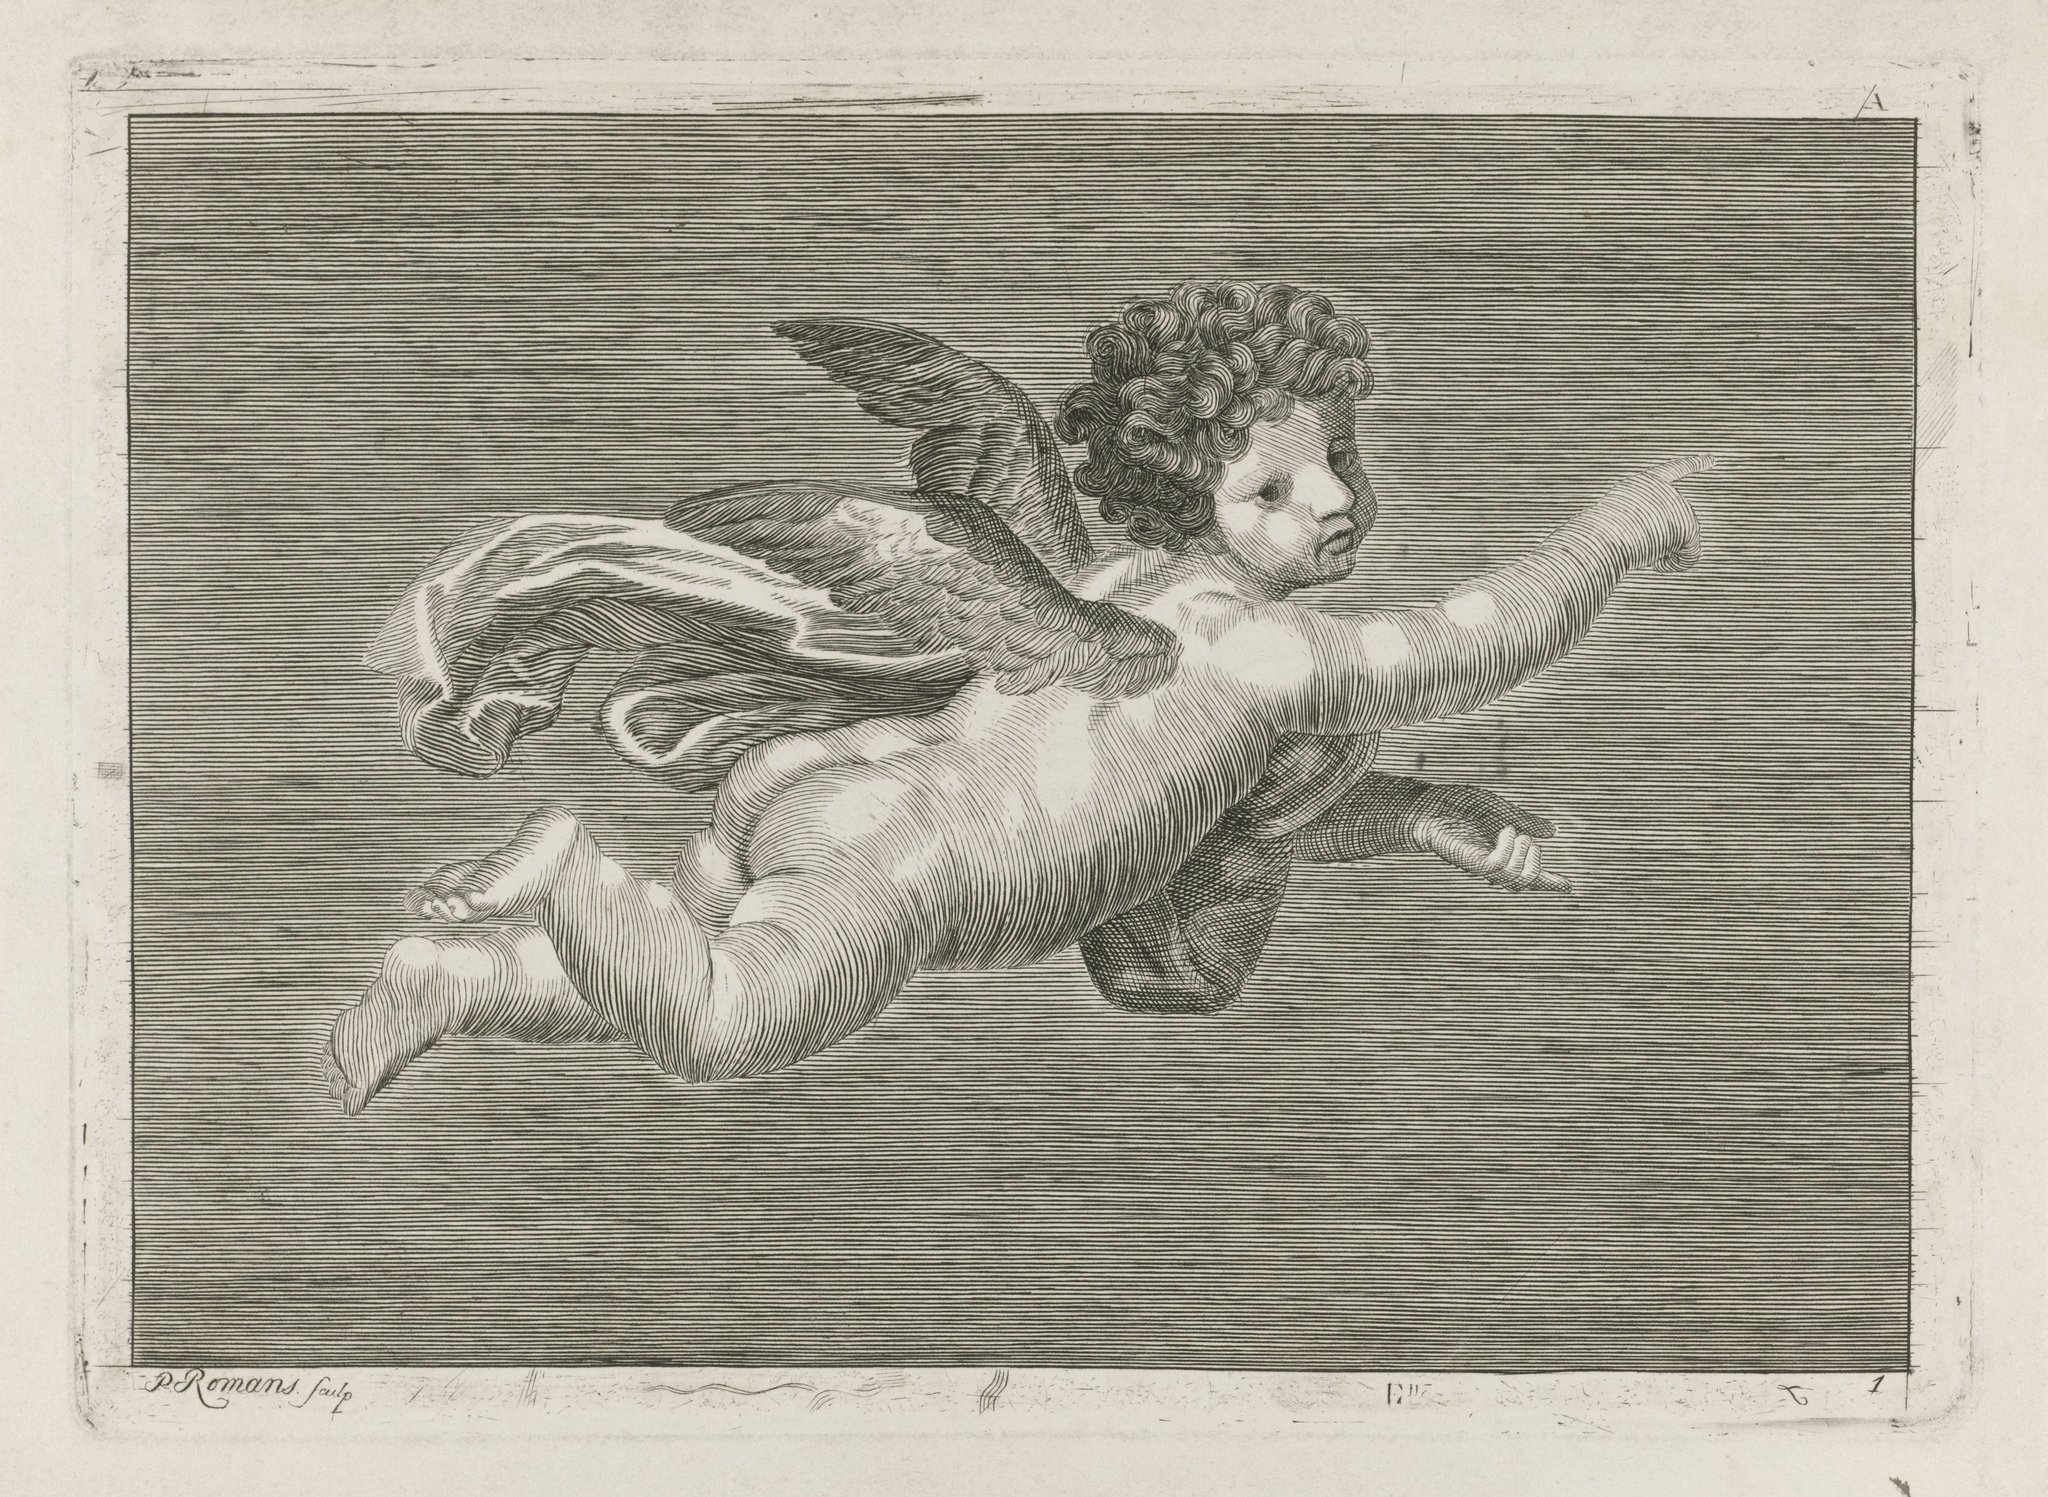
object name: print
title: Wijzende putto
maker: pieter romans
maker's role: draughtsman, print maker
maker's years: 1815-1835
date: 1825-1835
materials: paper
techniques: engraving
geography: amsterdam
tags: cupids: 'amores', 'amoretti', 'putti'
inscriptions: collector's mark: Lugt 2228